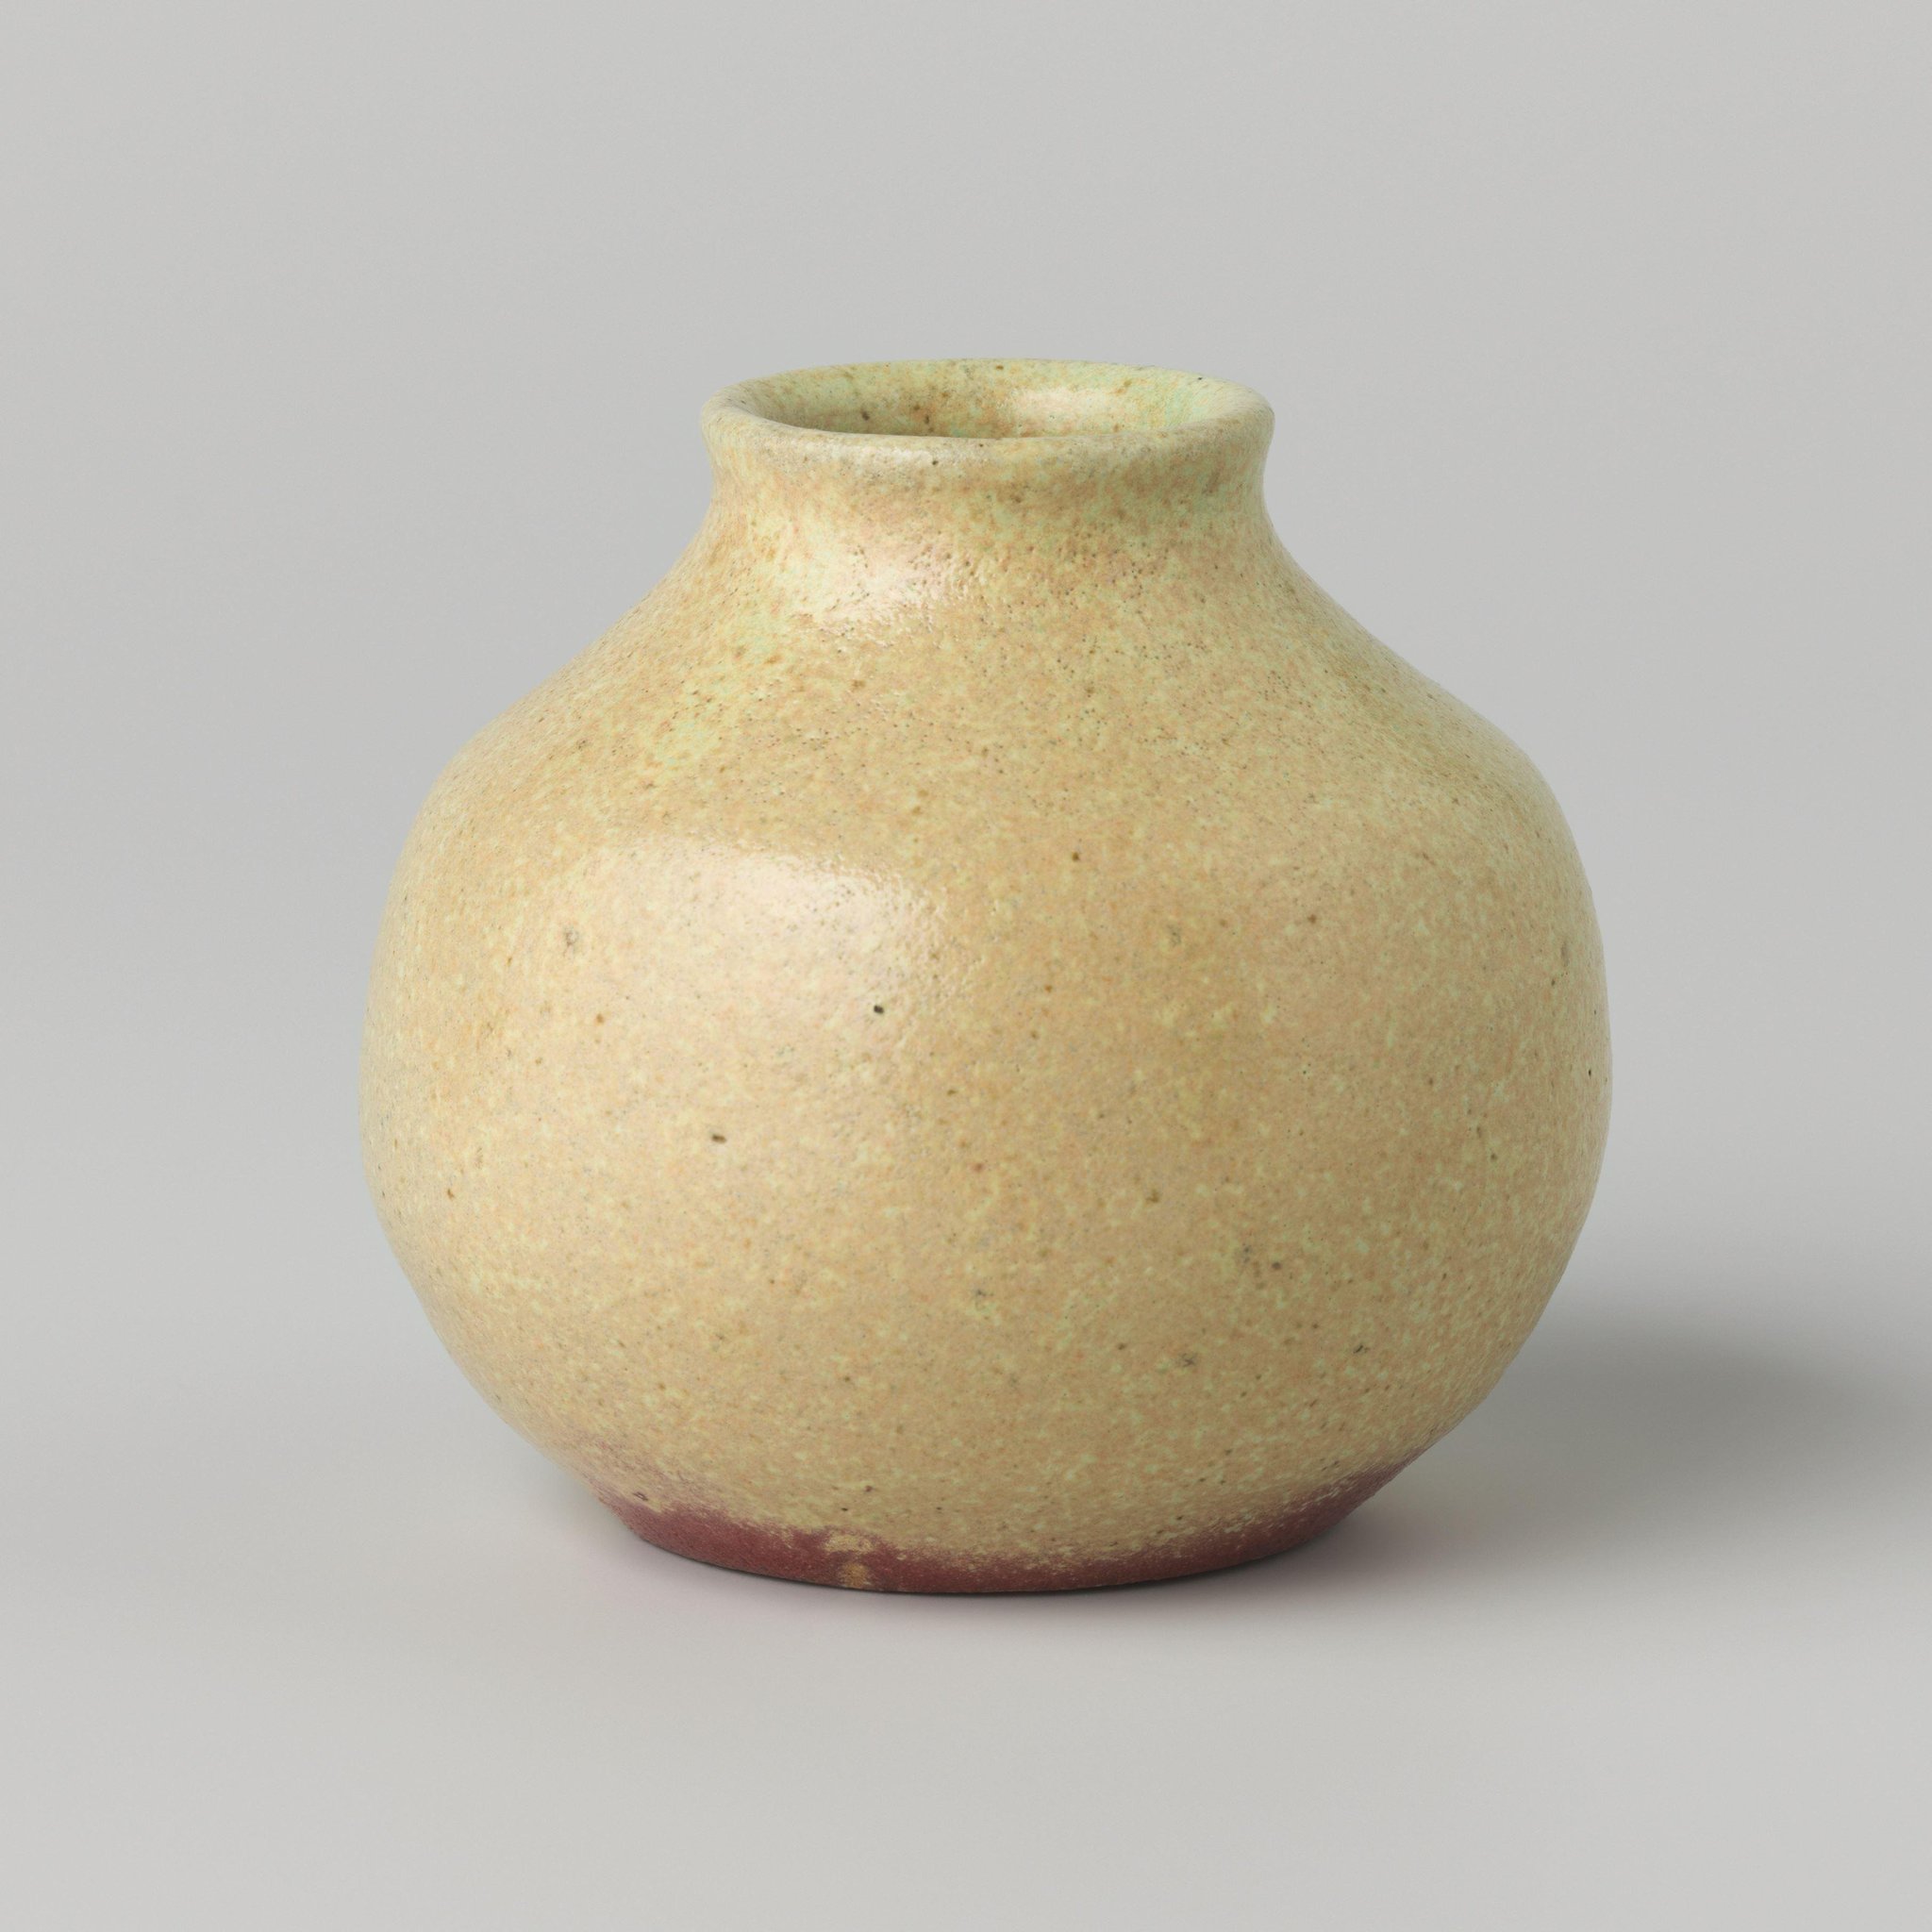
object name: pot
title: Pot with a Green-Beige Glaze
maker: chris lanooy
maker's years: 1881-1948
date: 1900-1920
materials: earthenware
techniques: vitrification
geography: netherlands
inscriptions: mark: ‘C J Lanooy’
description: Pot van aardewerk bedekt met groen-beige glazuur en een rode vlek op de onderkant.